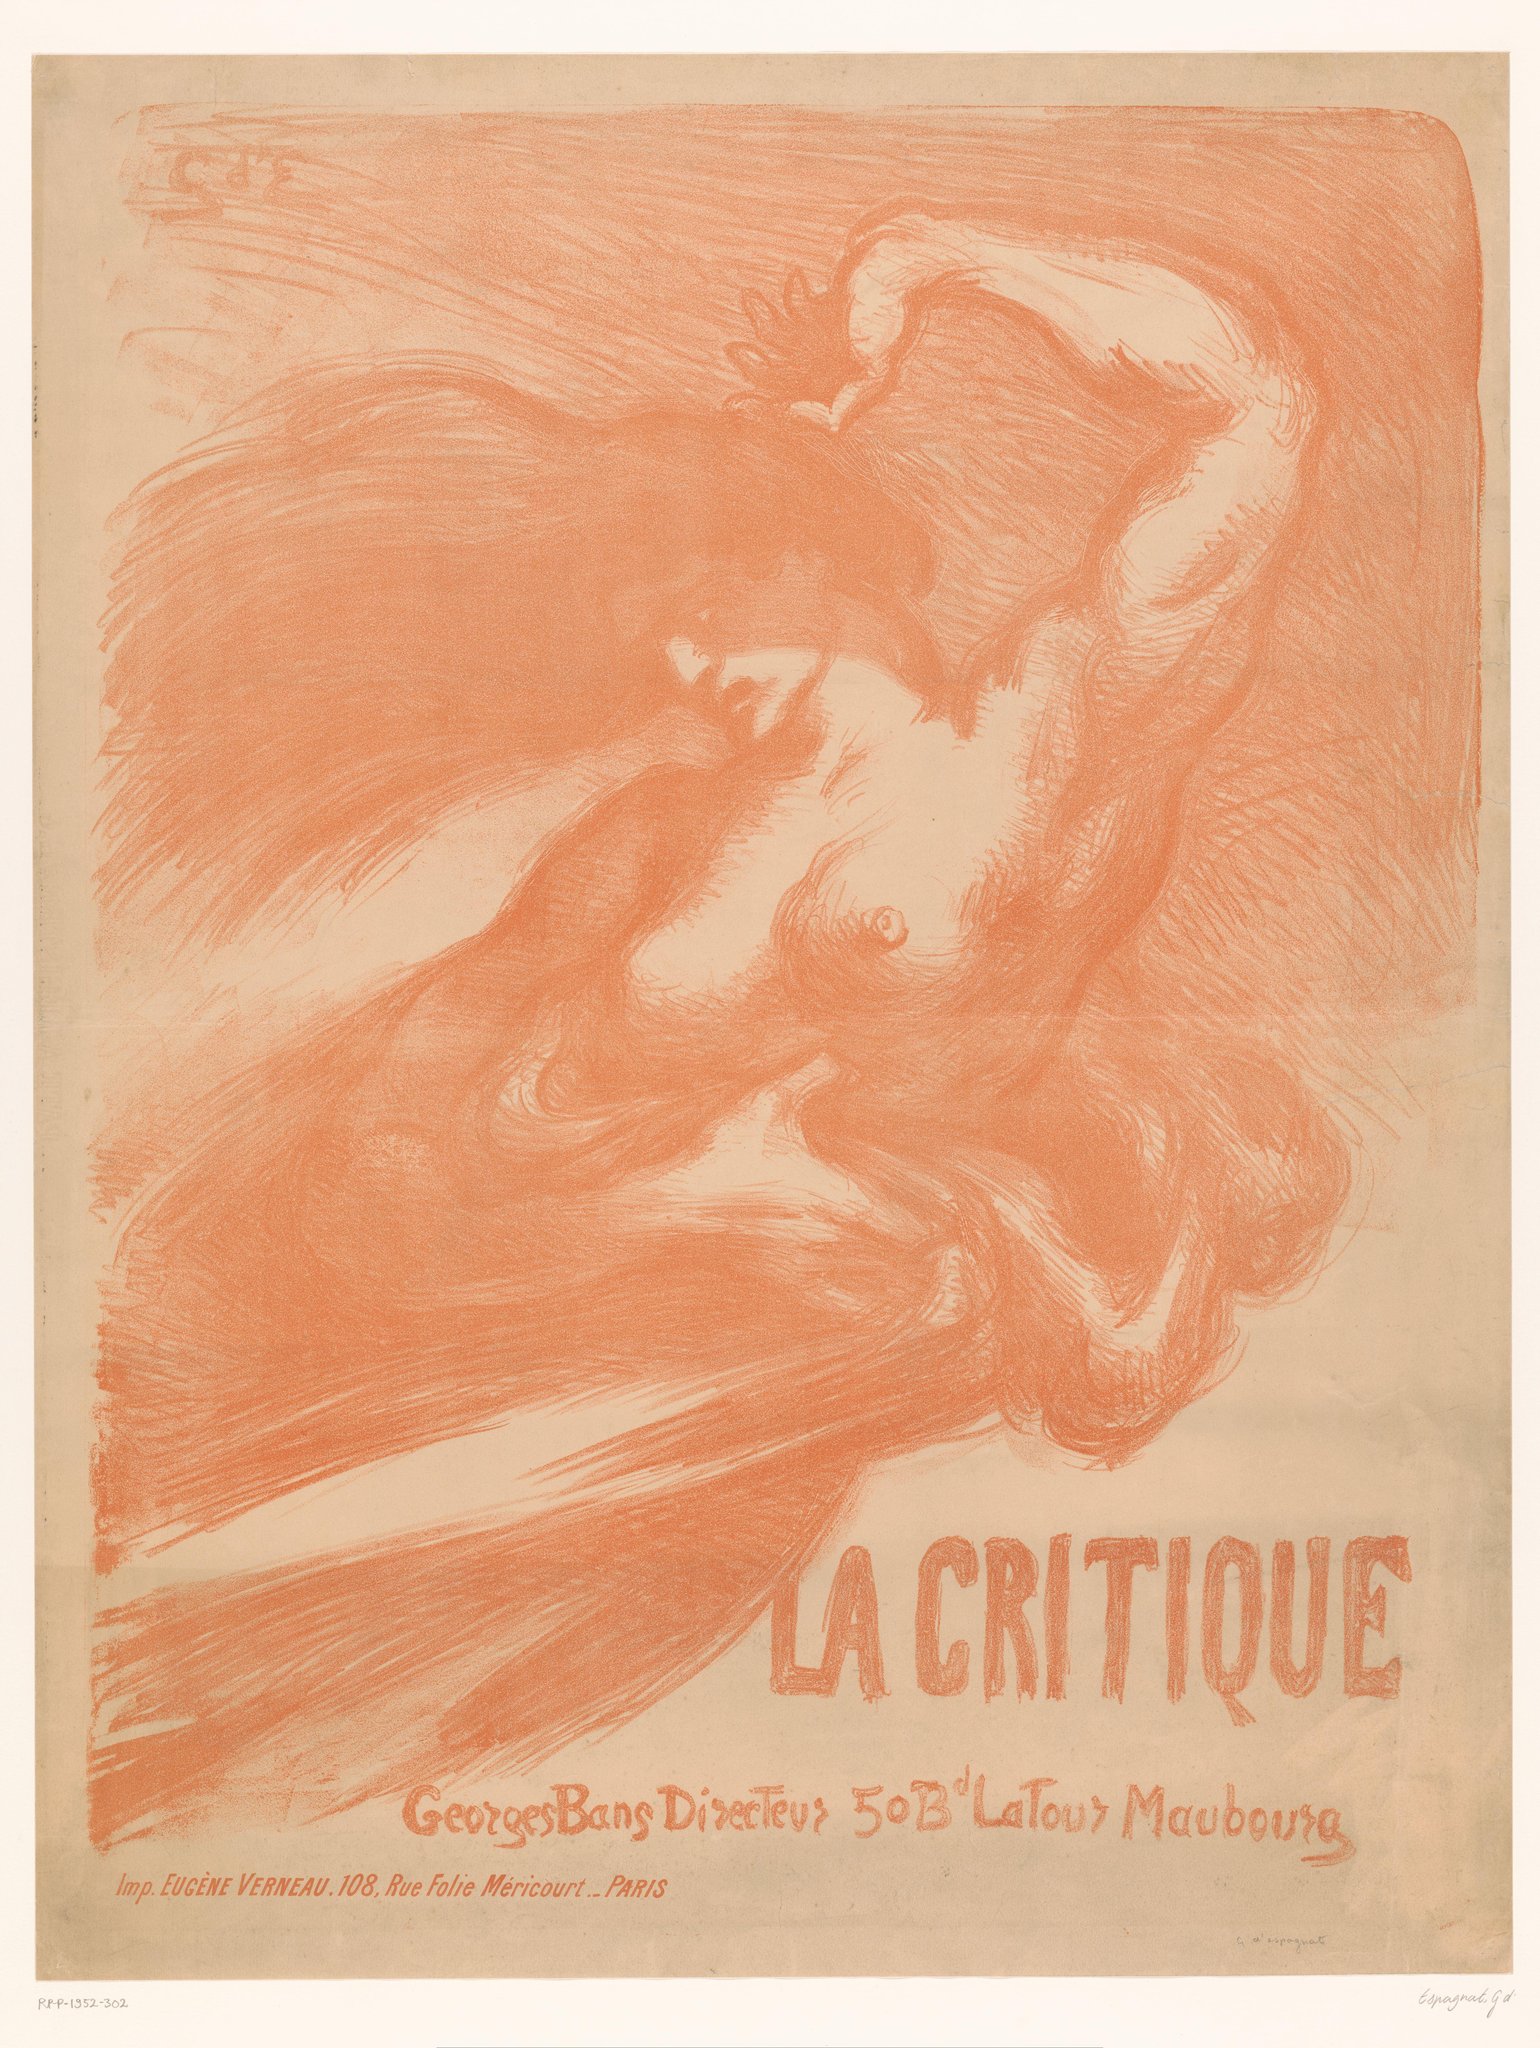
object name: print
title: La Critique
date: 1890-1900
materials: paper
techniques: lithography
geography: paris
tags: woman (showing herself) undressed, quasi-nude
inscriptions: collector's mark: Lugt 2228a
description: Prent gebruikt als aankondiging voor het tweemaandelijkse tijdschrift La Critique.